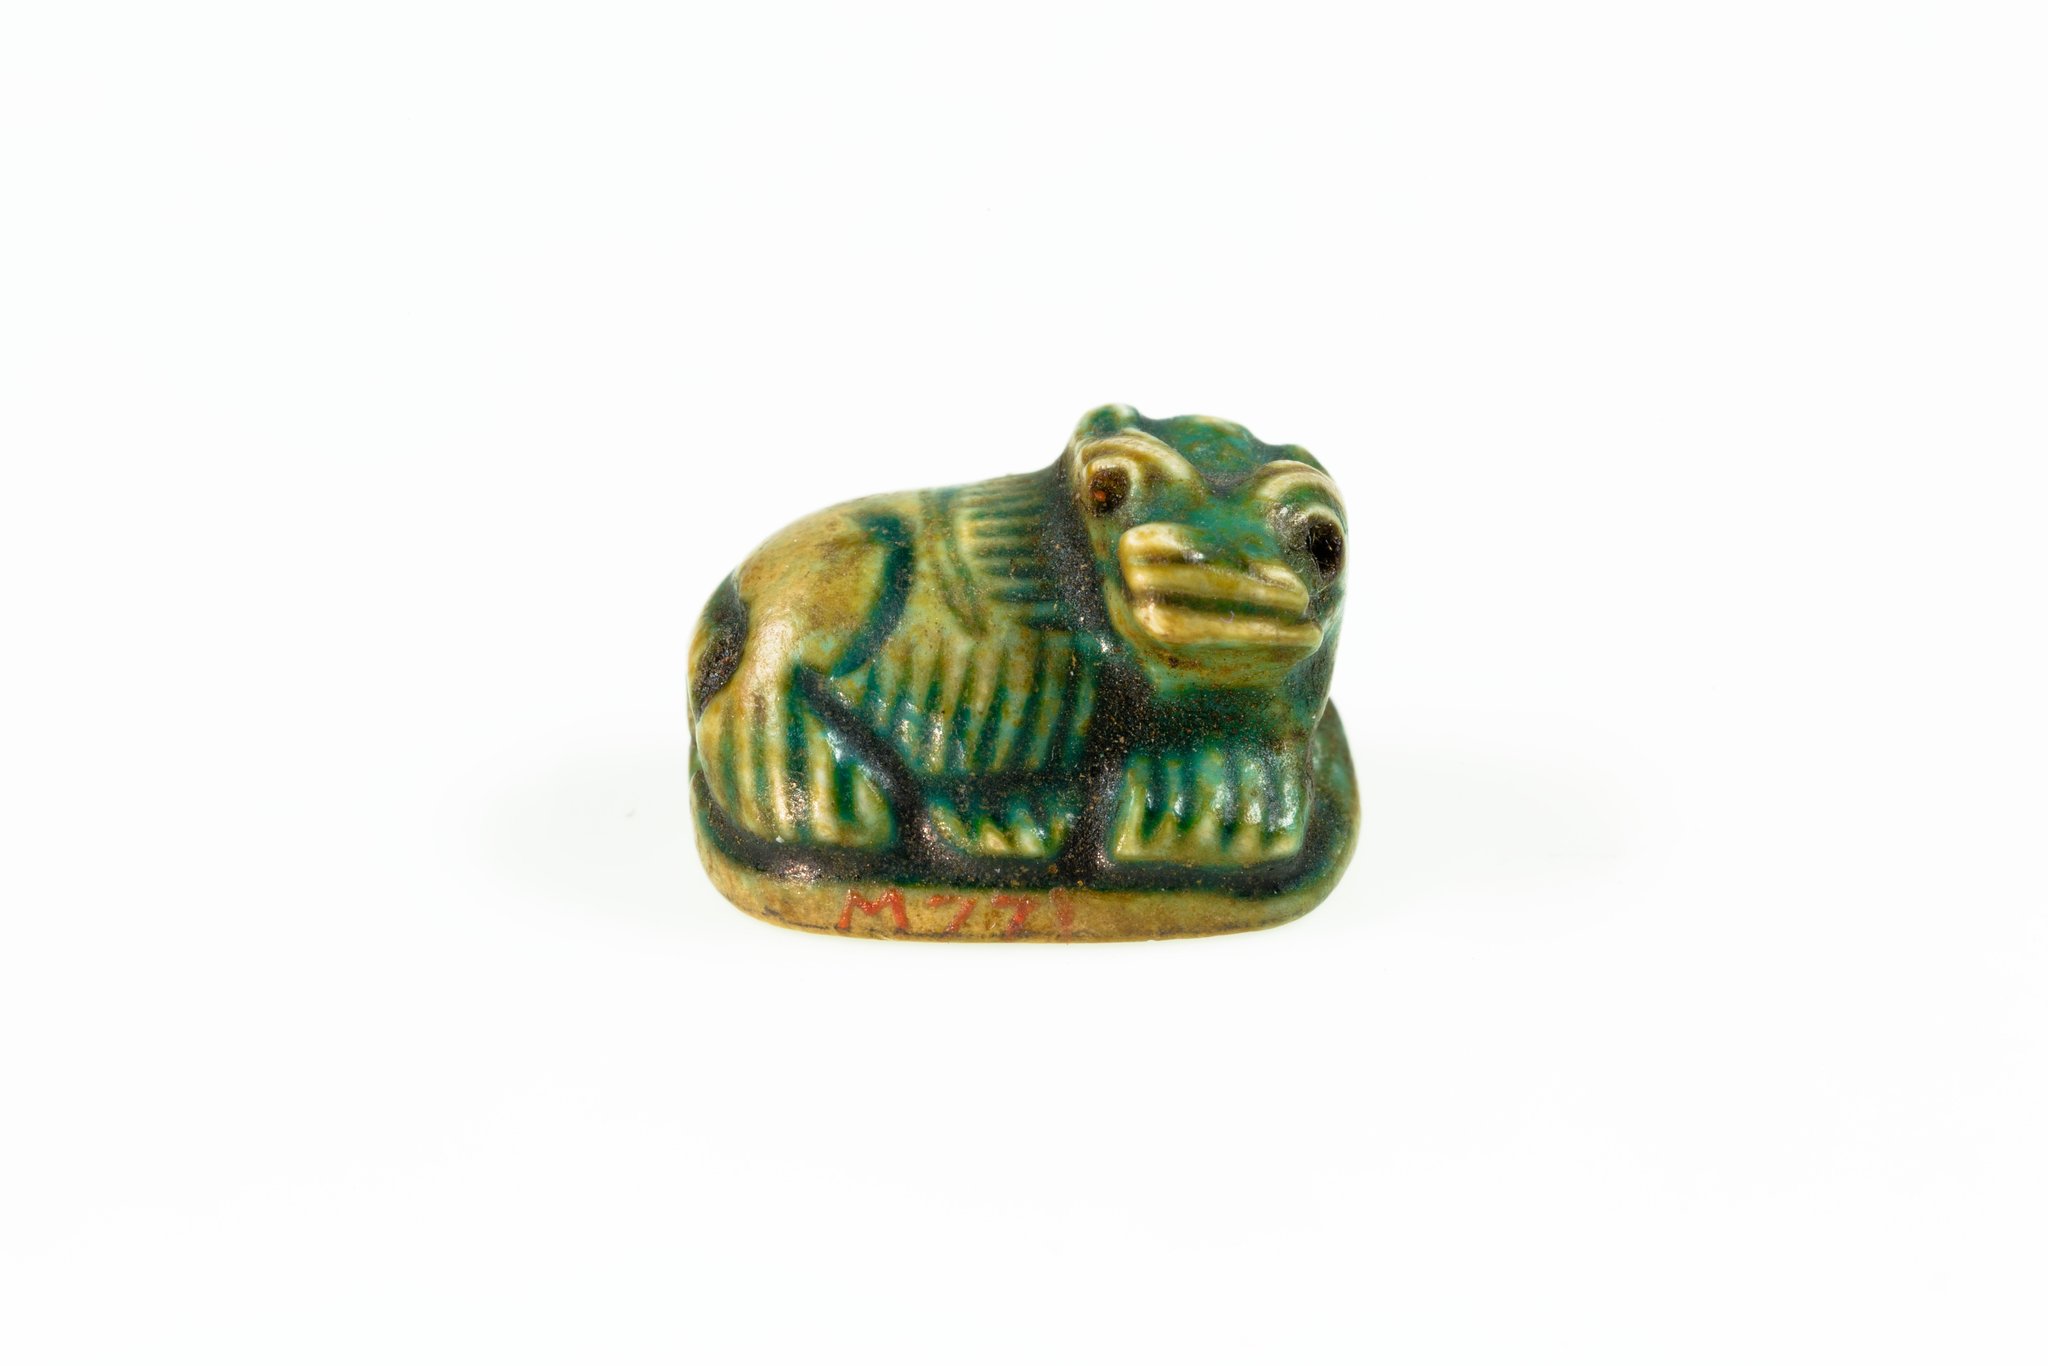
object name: scaraboid, hippopotamus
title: Seal Amulet in the Shape of a Hippopotamus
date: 1550-1295 BCE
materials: stone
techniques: glazing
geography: egypt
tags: animals